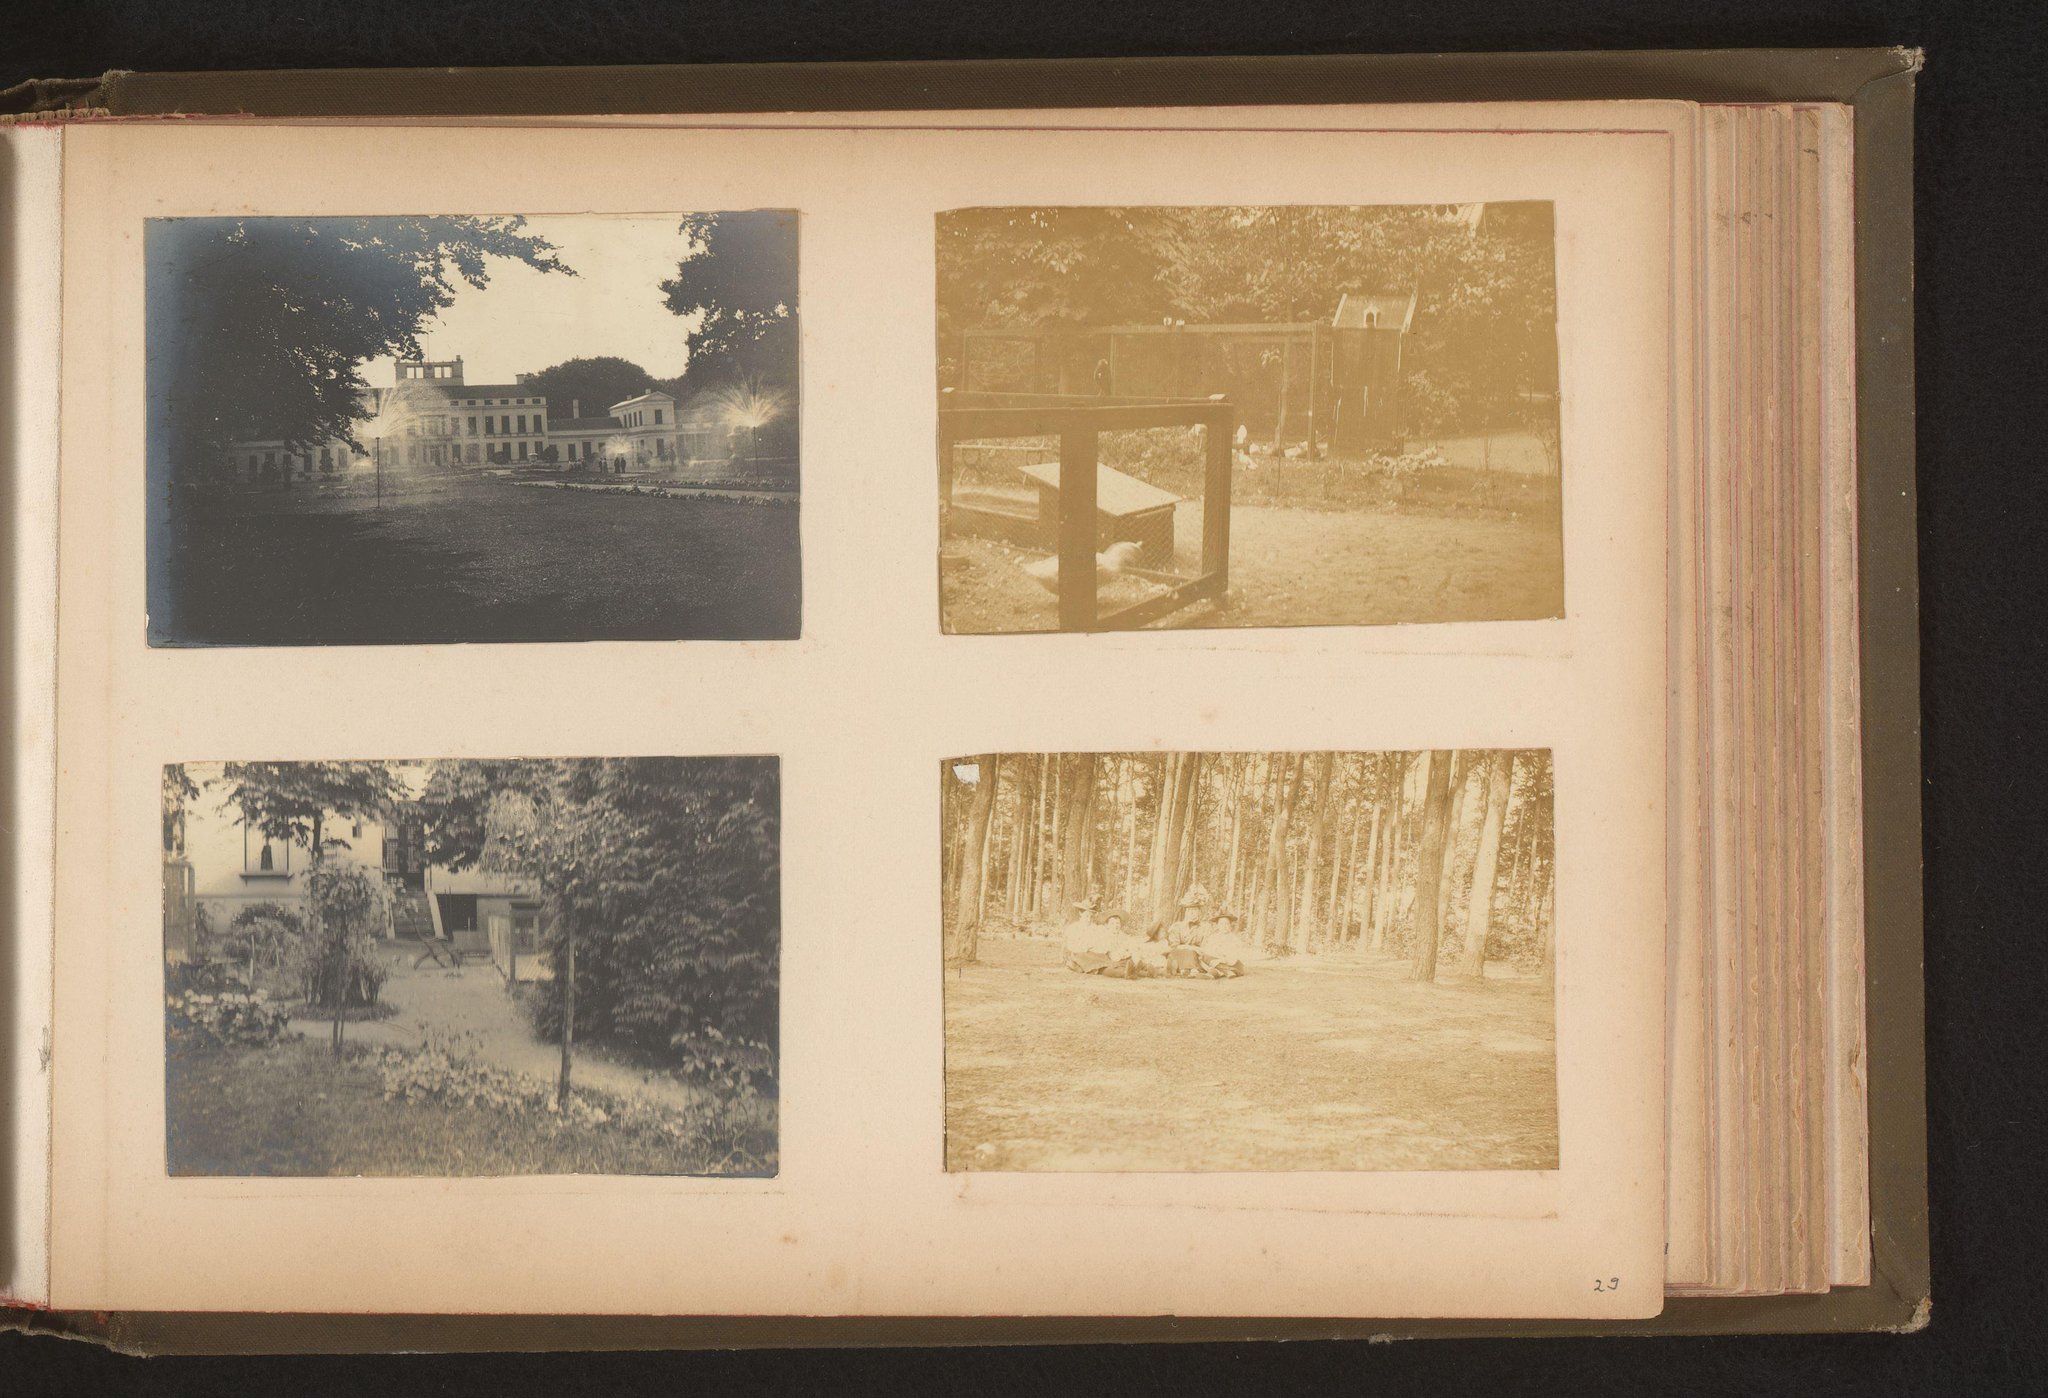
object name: photograph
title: Vier foto's van paleis Soestdijk, tuinen en een familie in een bos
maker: Anonymous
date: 1895-1910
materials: paper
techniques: gelatin silver print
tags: palace, forest, wood, mother and child(ren), woman and child(ren) (family group), netherlands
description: Deze foto's maken deel uit van een album.